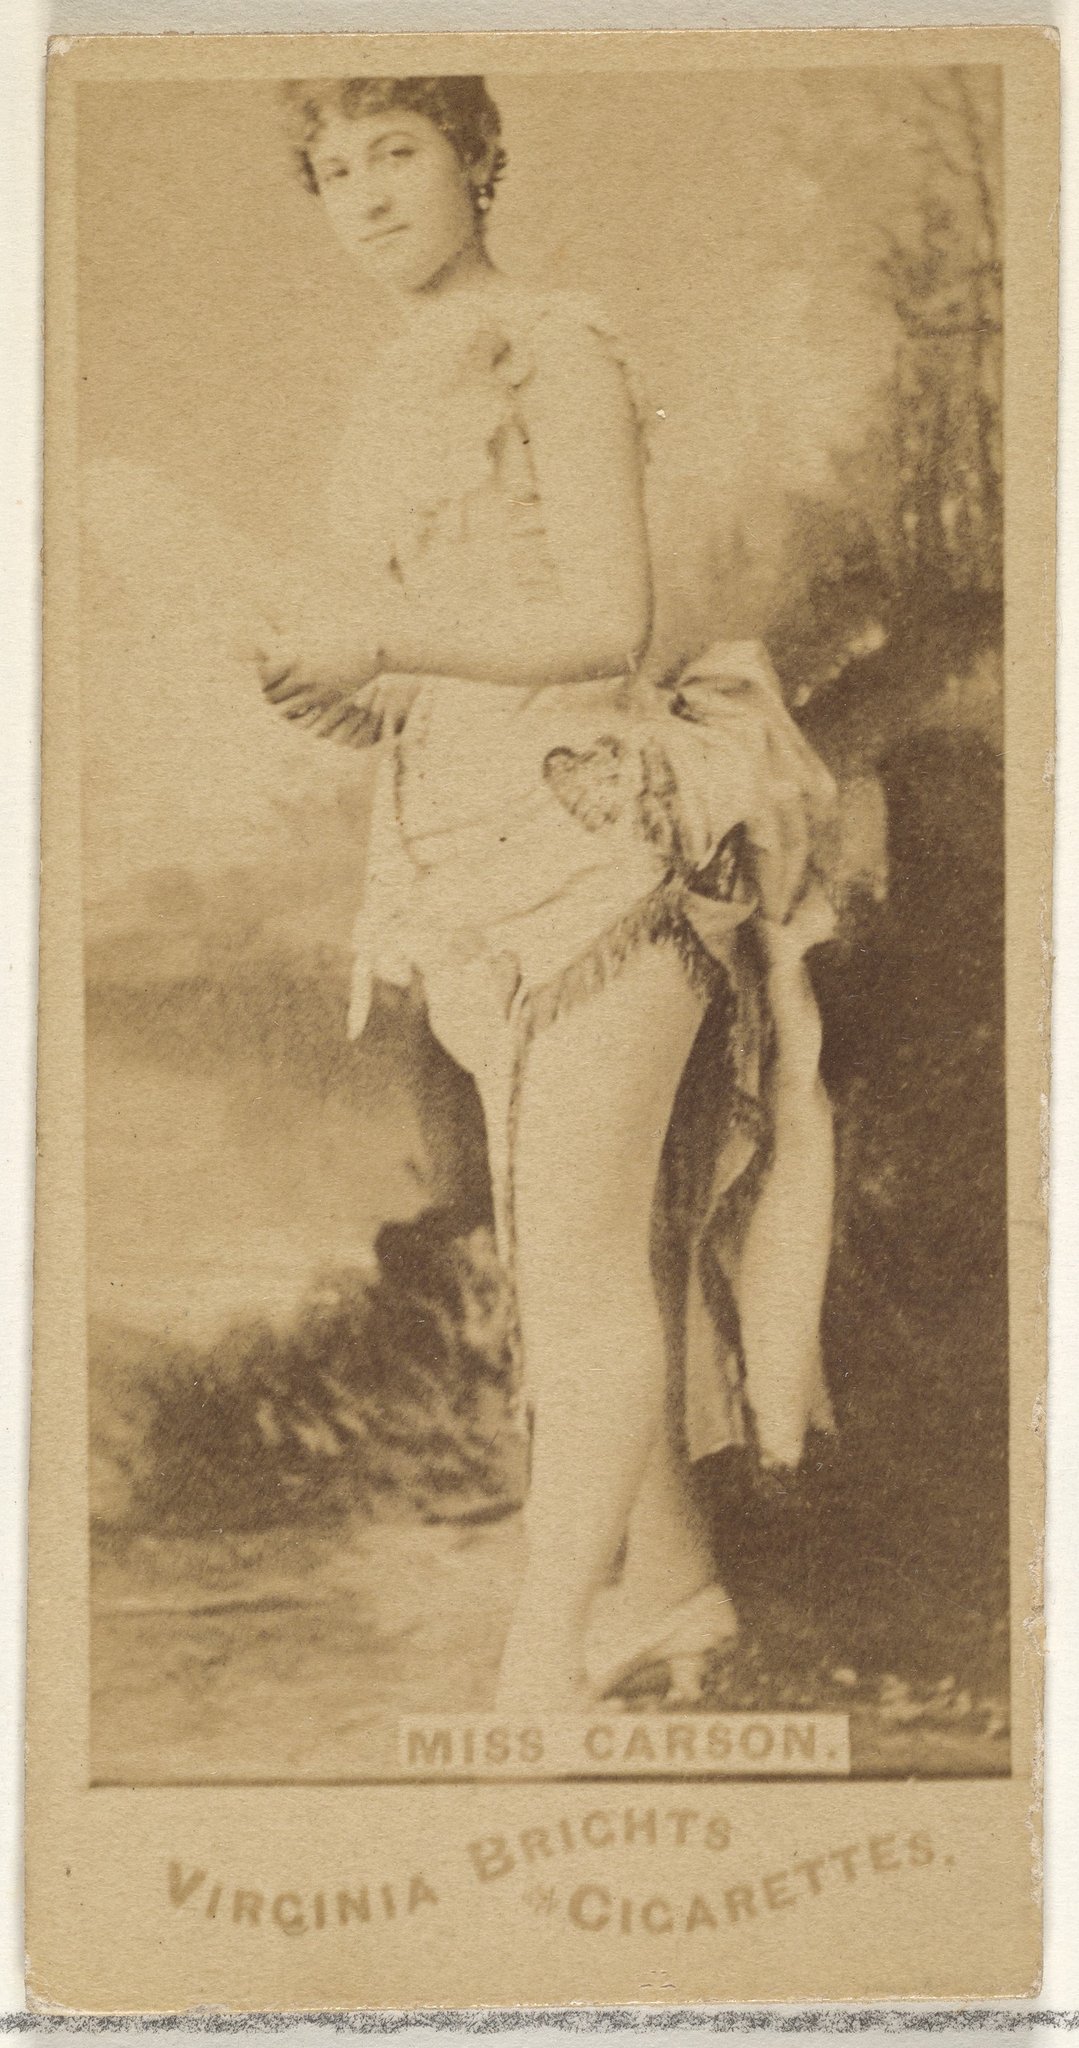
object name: photograph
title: Miss Carson, from the Actors and Actresses series (N45, Type 1) for Virginia Brights Cigarettes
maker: allen & ginter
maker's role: publisher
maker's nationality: american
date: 1888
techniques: albumen silver print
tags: portraits,women,actresses